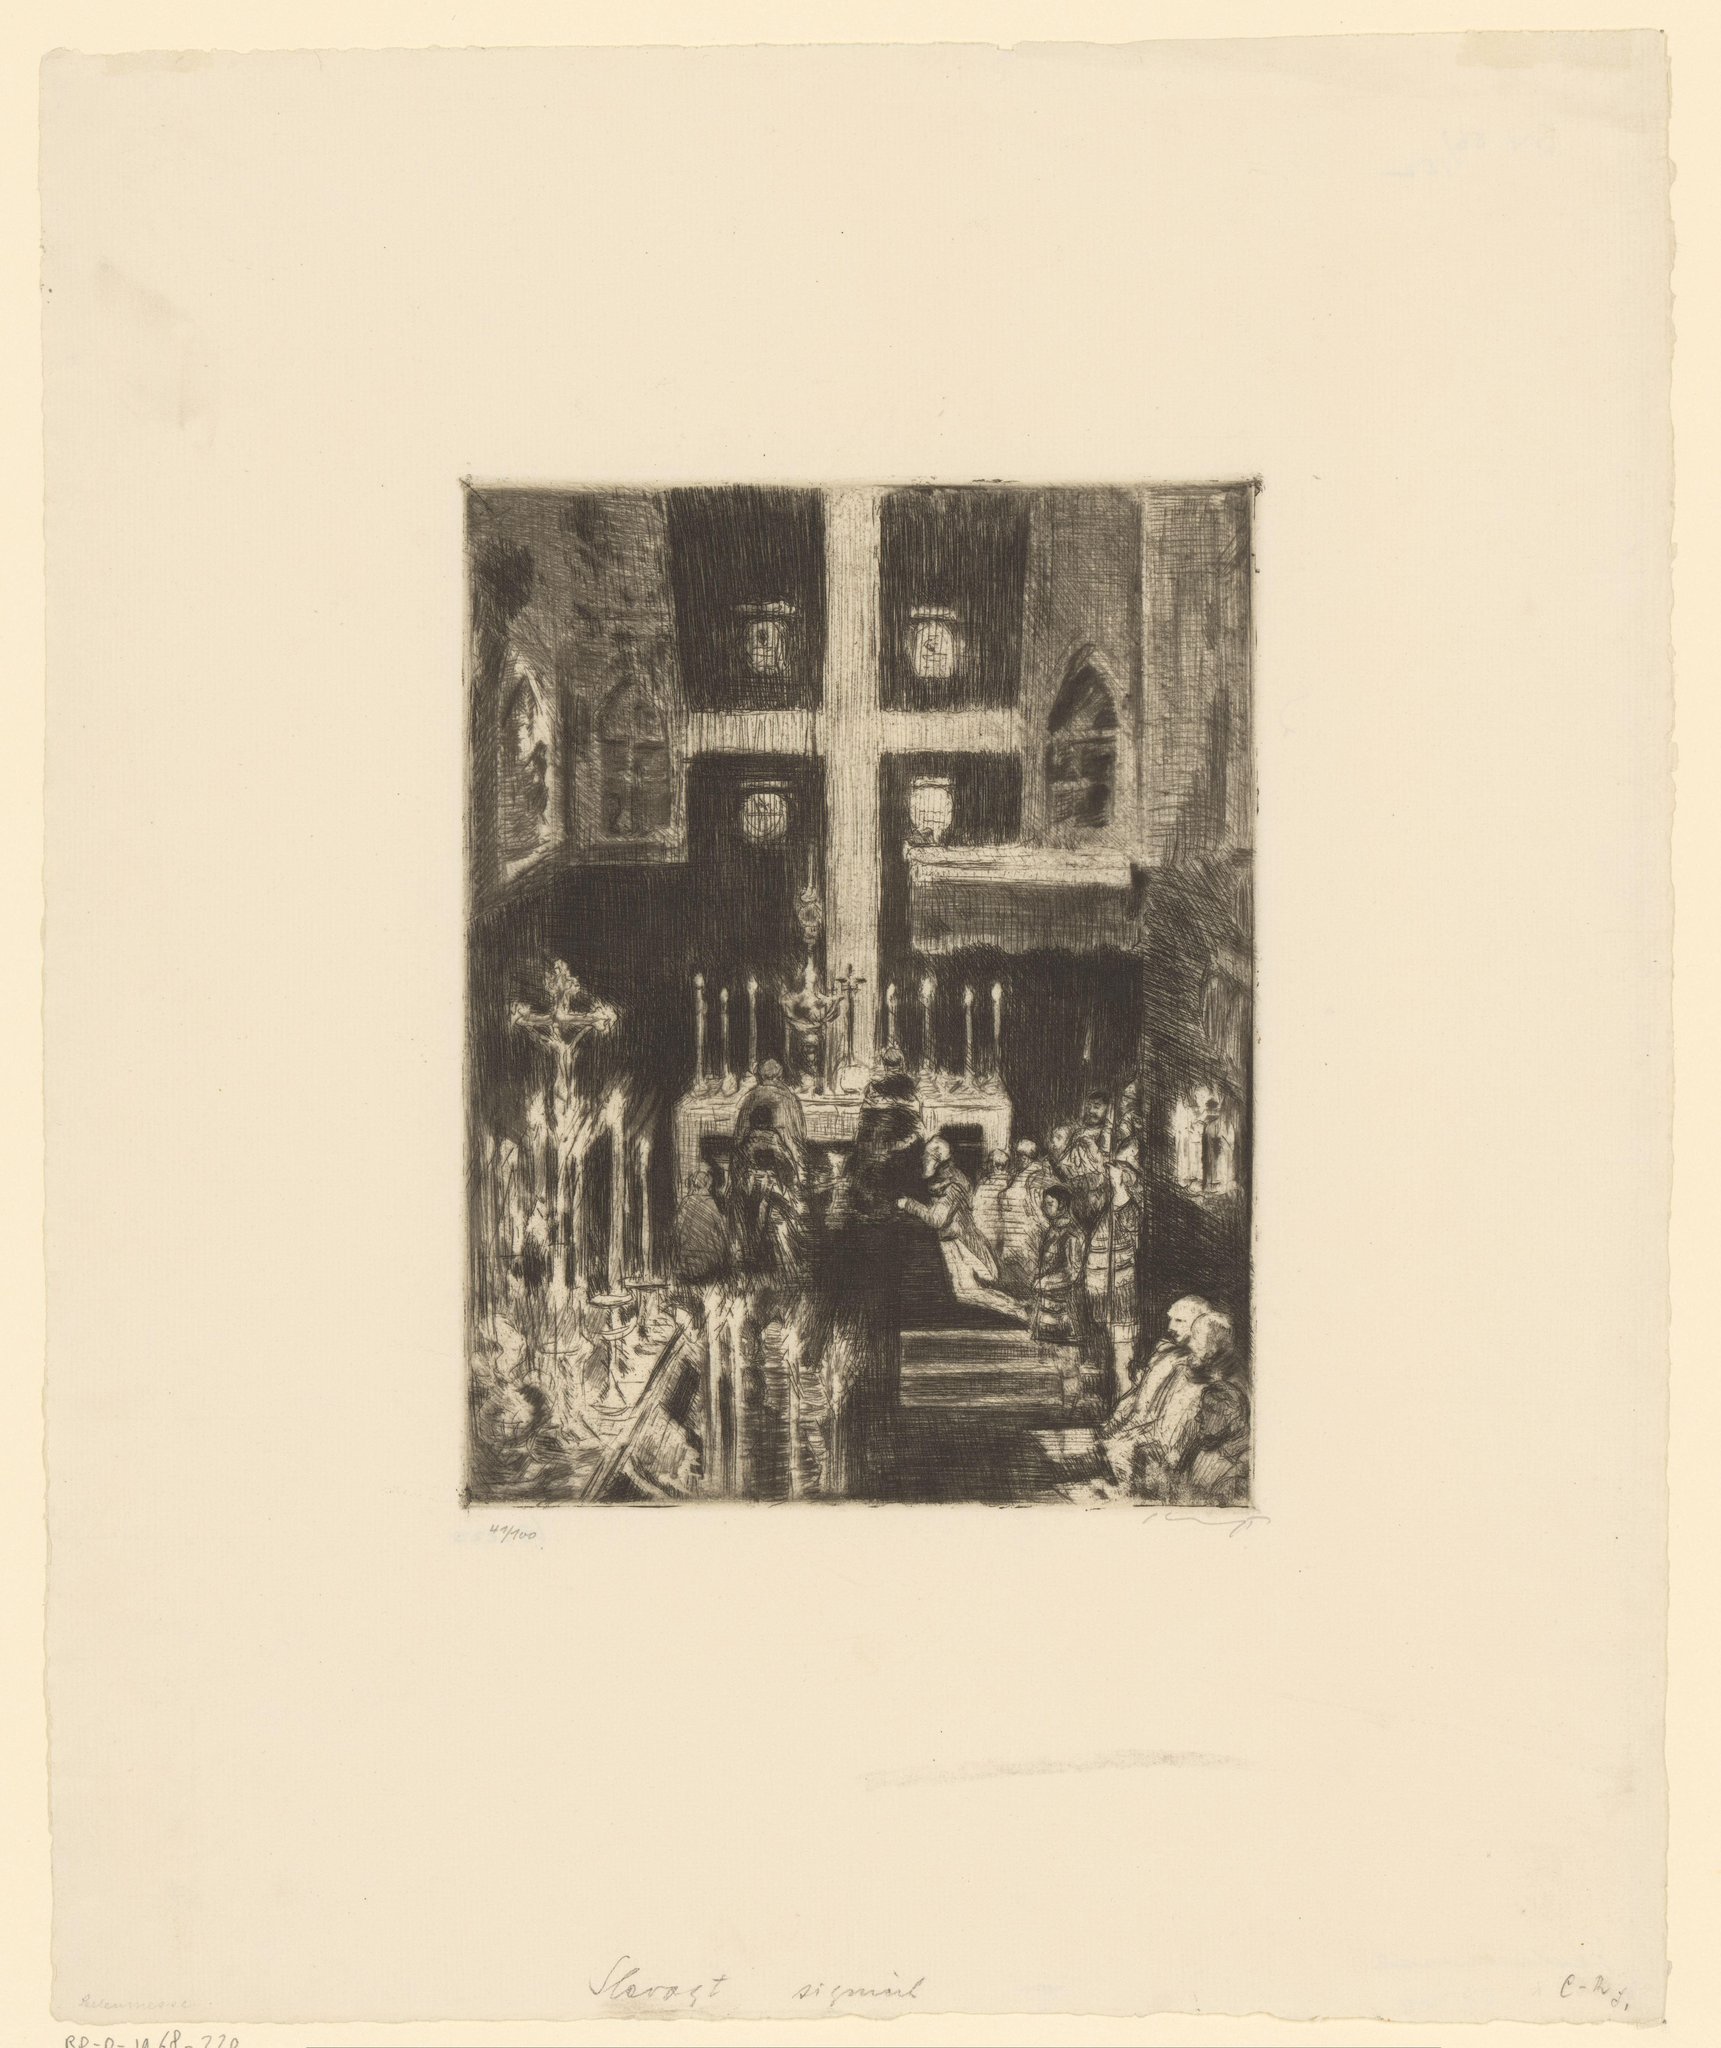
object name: print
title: Kerkdienst van Georgiritter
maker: max slevogt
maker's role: print maker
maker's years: 1868-1932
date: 1911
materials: paper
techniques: drypoint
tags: knighthood order, sermon ~ holy mass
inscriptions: collector's mark: Lugt 2760, signature: ‘Slevogt’, collector's mark: Lugt 2228, number: ‘41/100’